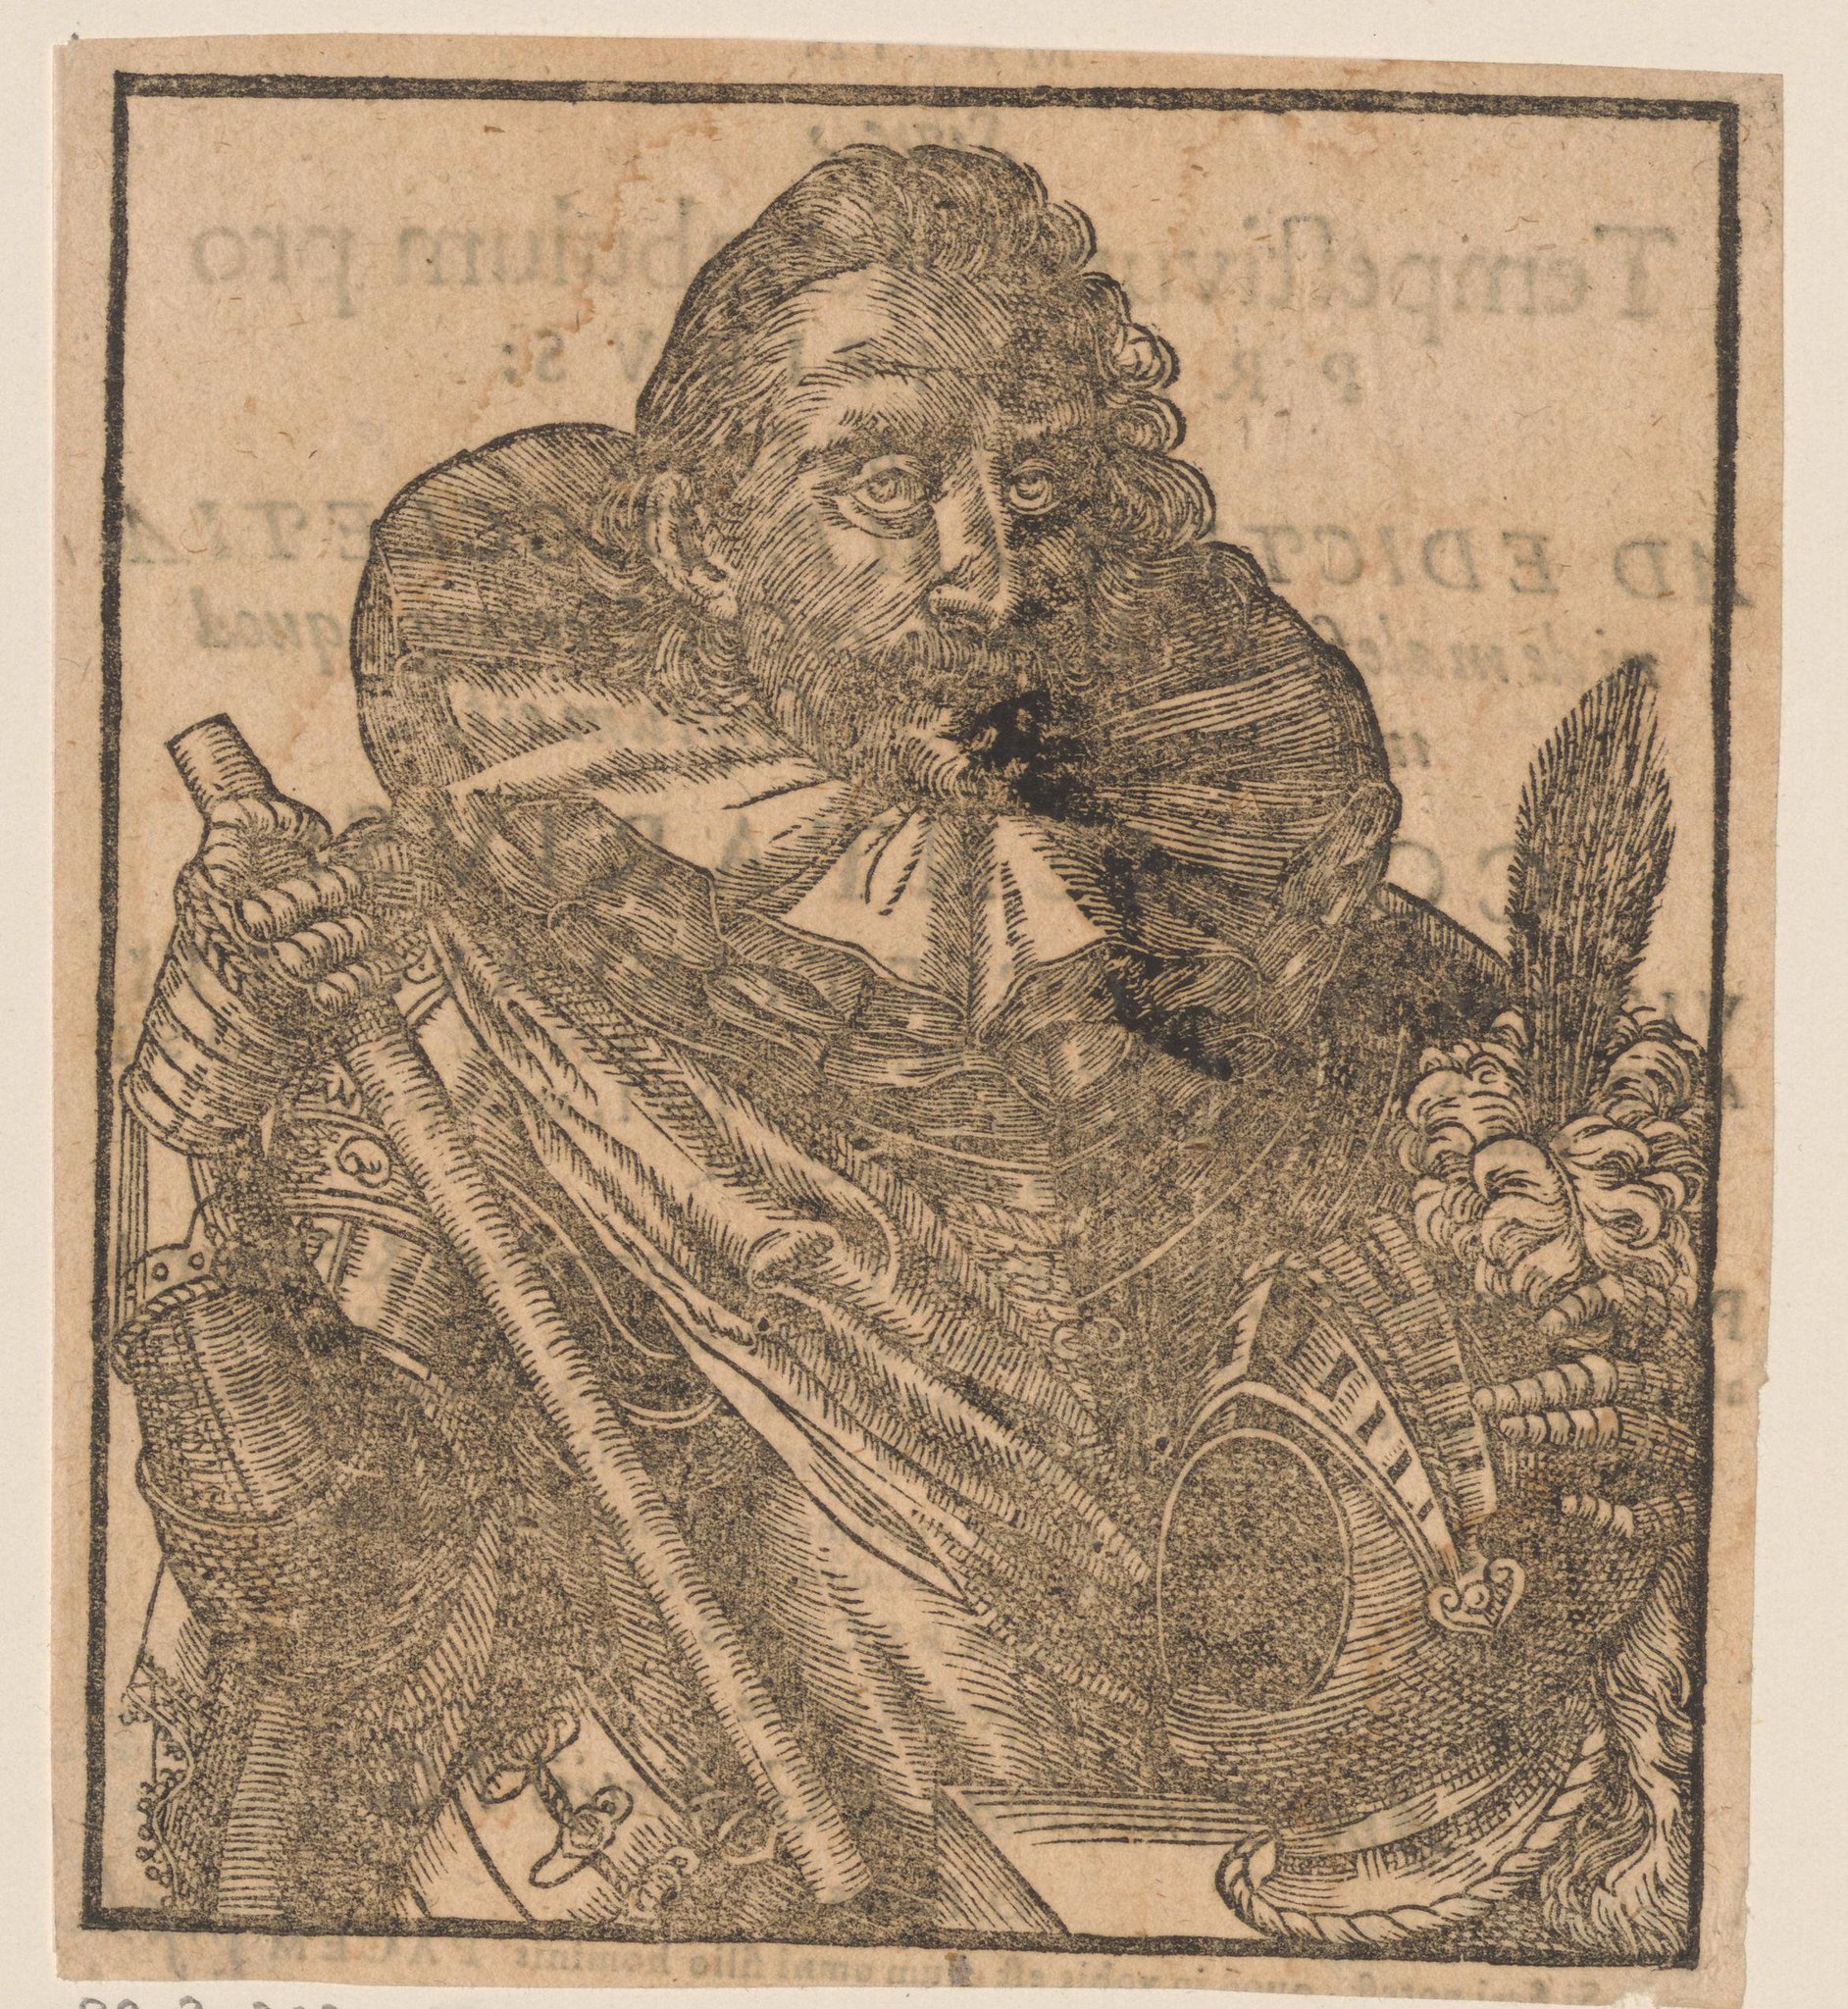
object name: print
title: Portret van Hendrik Julius van Brunswijk-Wolffenbüttel, bisschop van Halberstadt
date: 1602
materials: paper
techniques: letterpress printing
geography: zerbst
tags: armour, historical persons, baton of general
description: Prent uit: Godentius, Antonius Benbellona de. Ung resveille matin sive tempestivum suscitabulum pro principibus (...). Zerbst: Jakob Zanach, 1602.